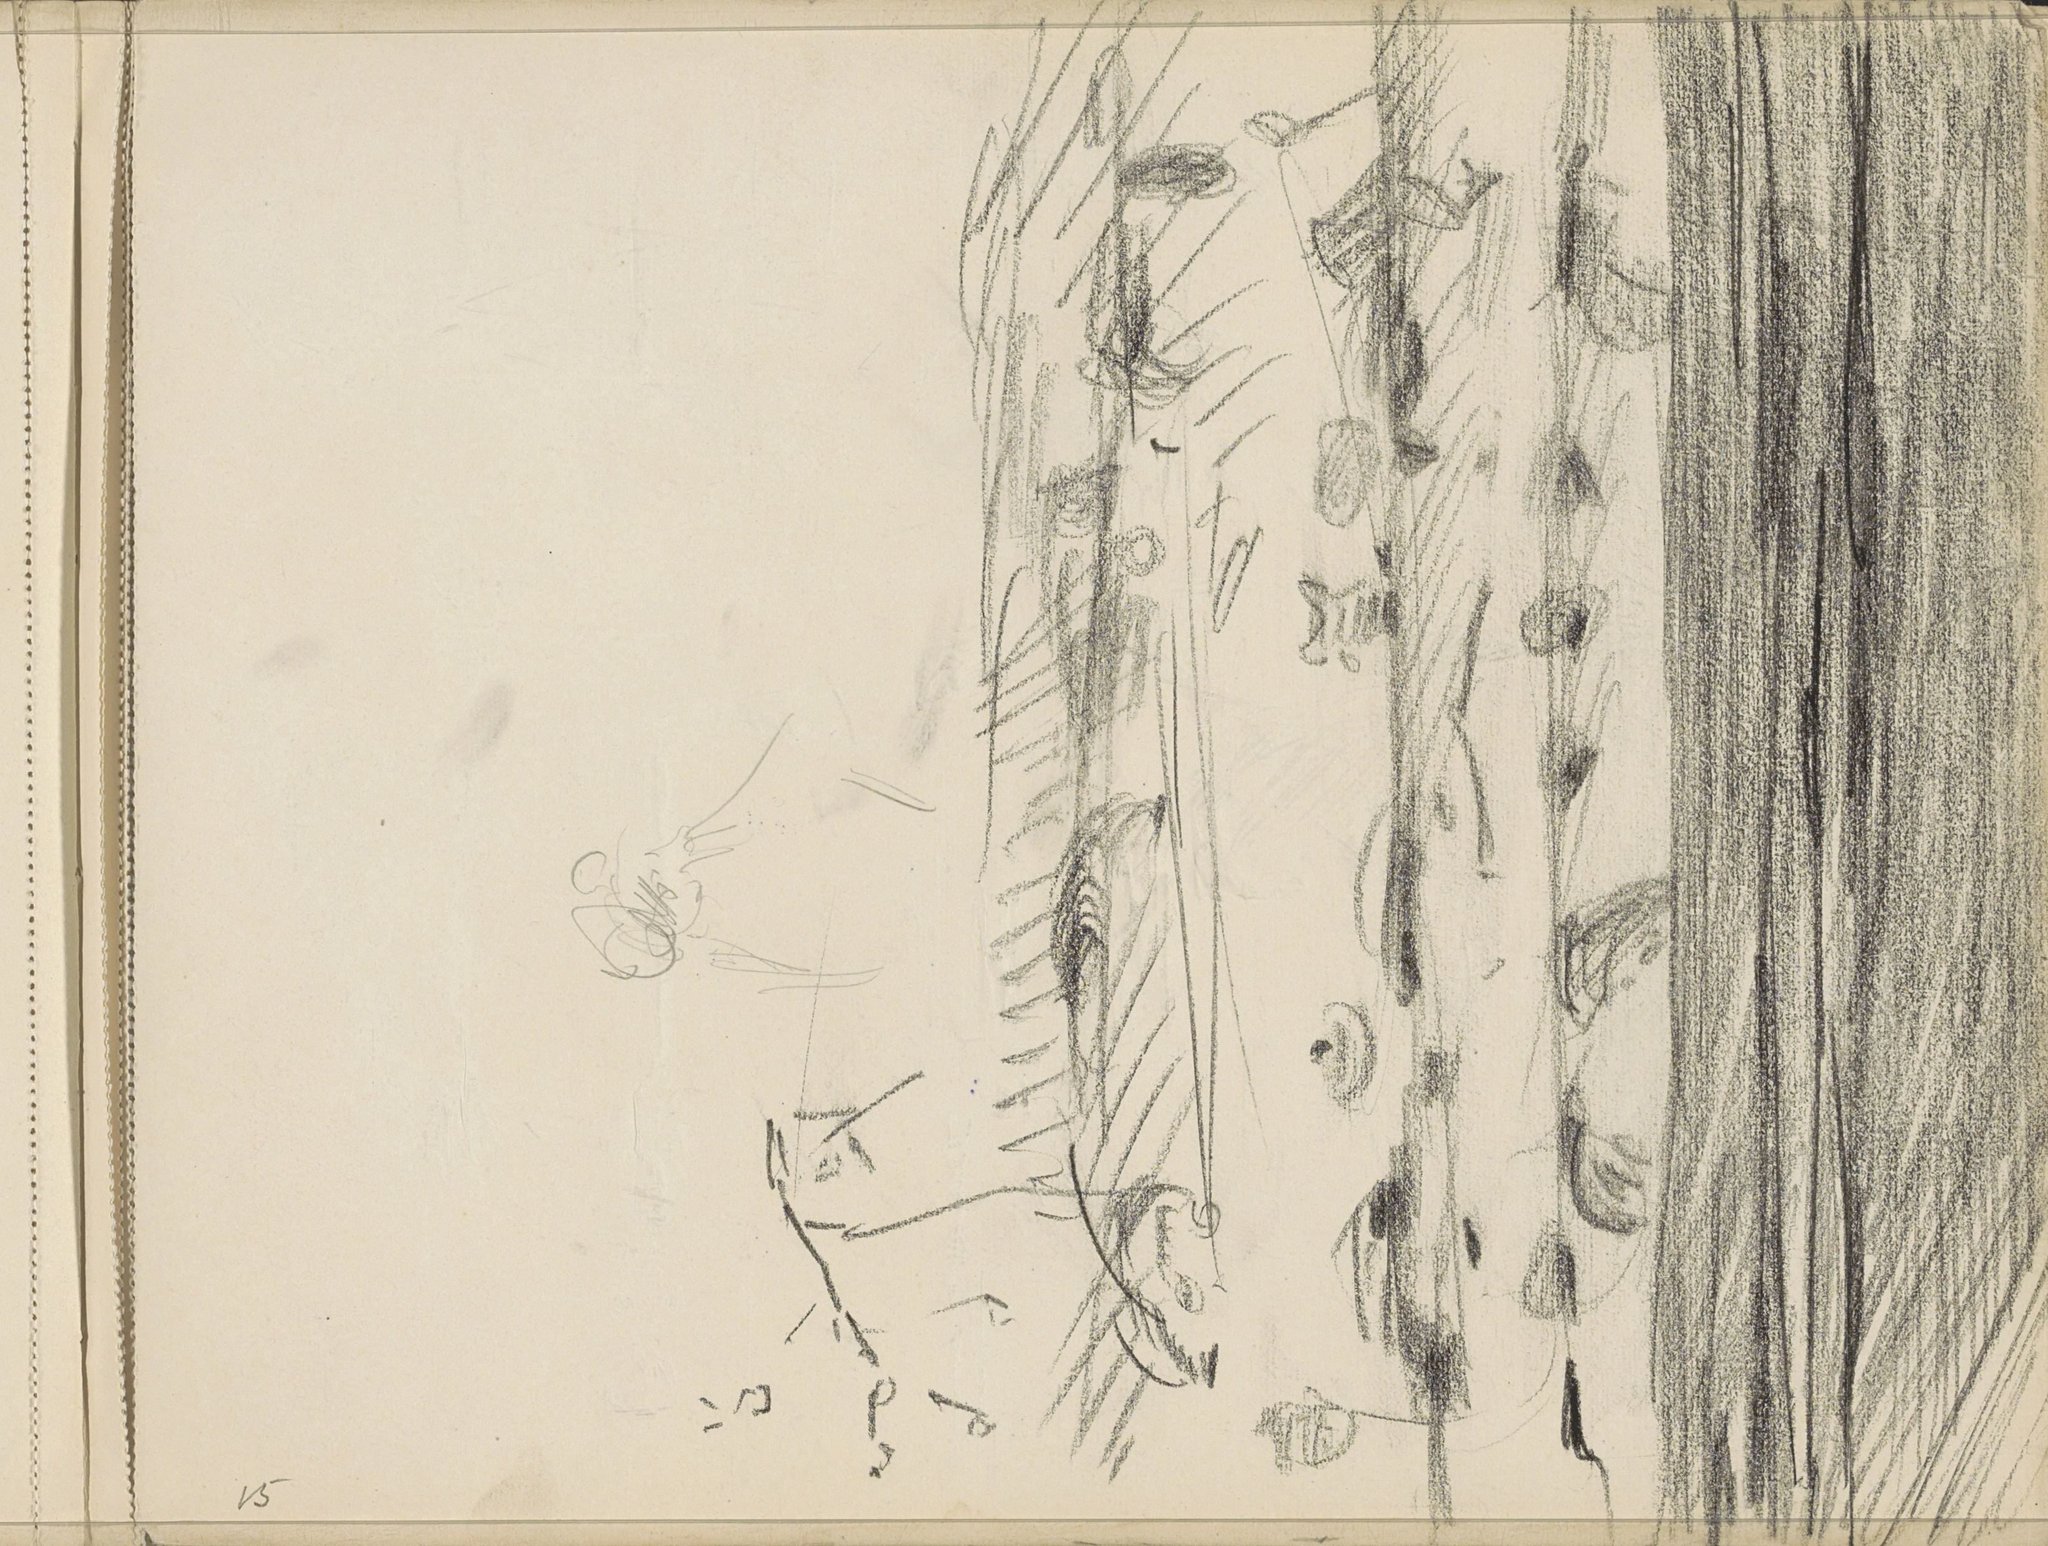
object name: sketchbook leaf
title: Studie, mogelijk van gordijnen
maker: isaac israels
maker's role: draughtsman, painter, print maker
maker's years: 1865-1934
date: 1875-1934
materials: chalk, paper, pencil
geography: the hague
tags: hangings and drapery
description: Blad 15 recto uit schetsboek XXIII met 20 bladen.